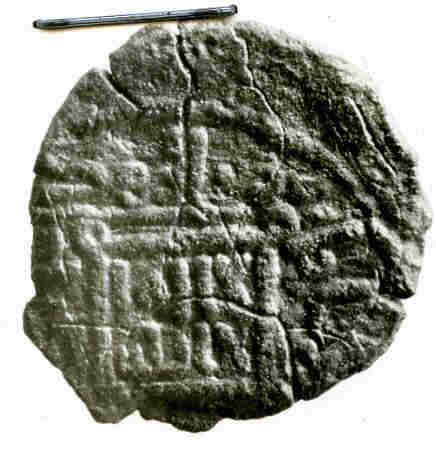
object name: coin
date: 701-833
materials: copper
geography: iran